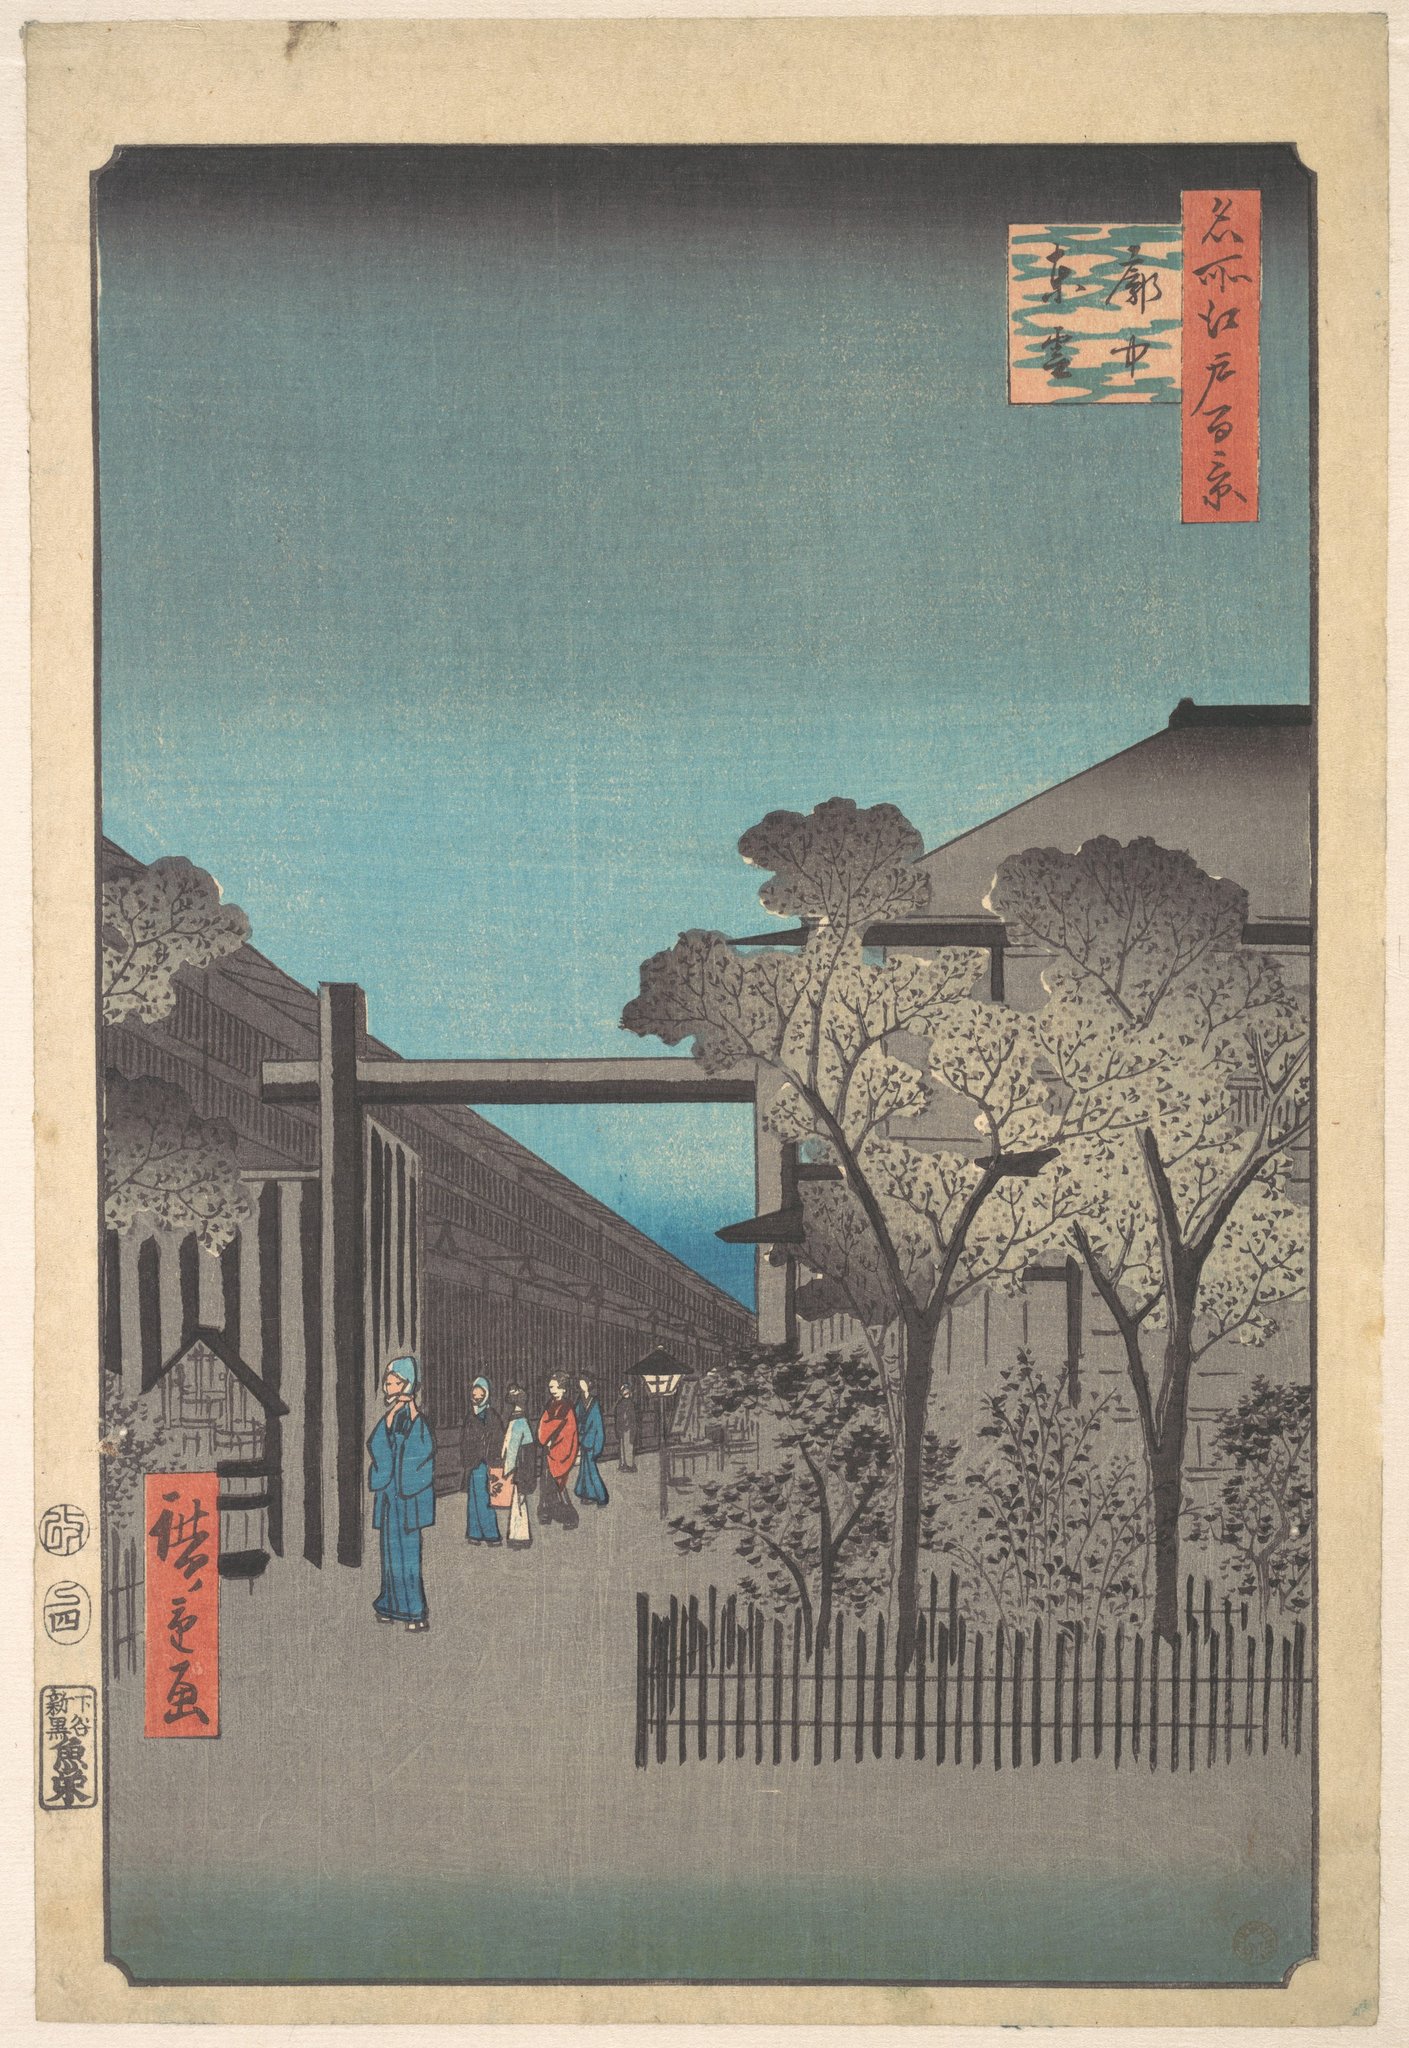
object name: print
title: Kakuchu Shinonome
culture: japanese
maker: utagawa hiroshige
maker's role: artist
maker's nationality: japanese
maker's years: 1797-1858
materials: ink, paper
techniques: woodblock print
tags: gates,men,women,trees